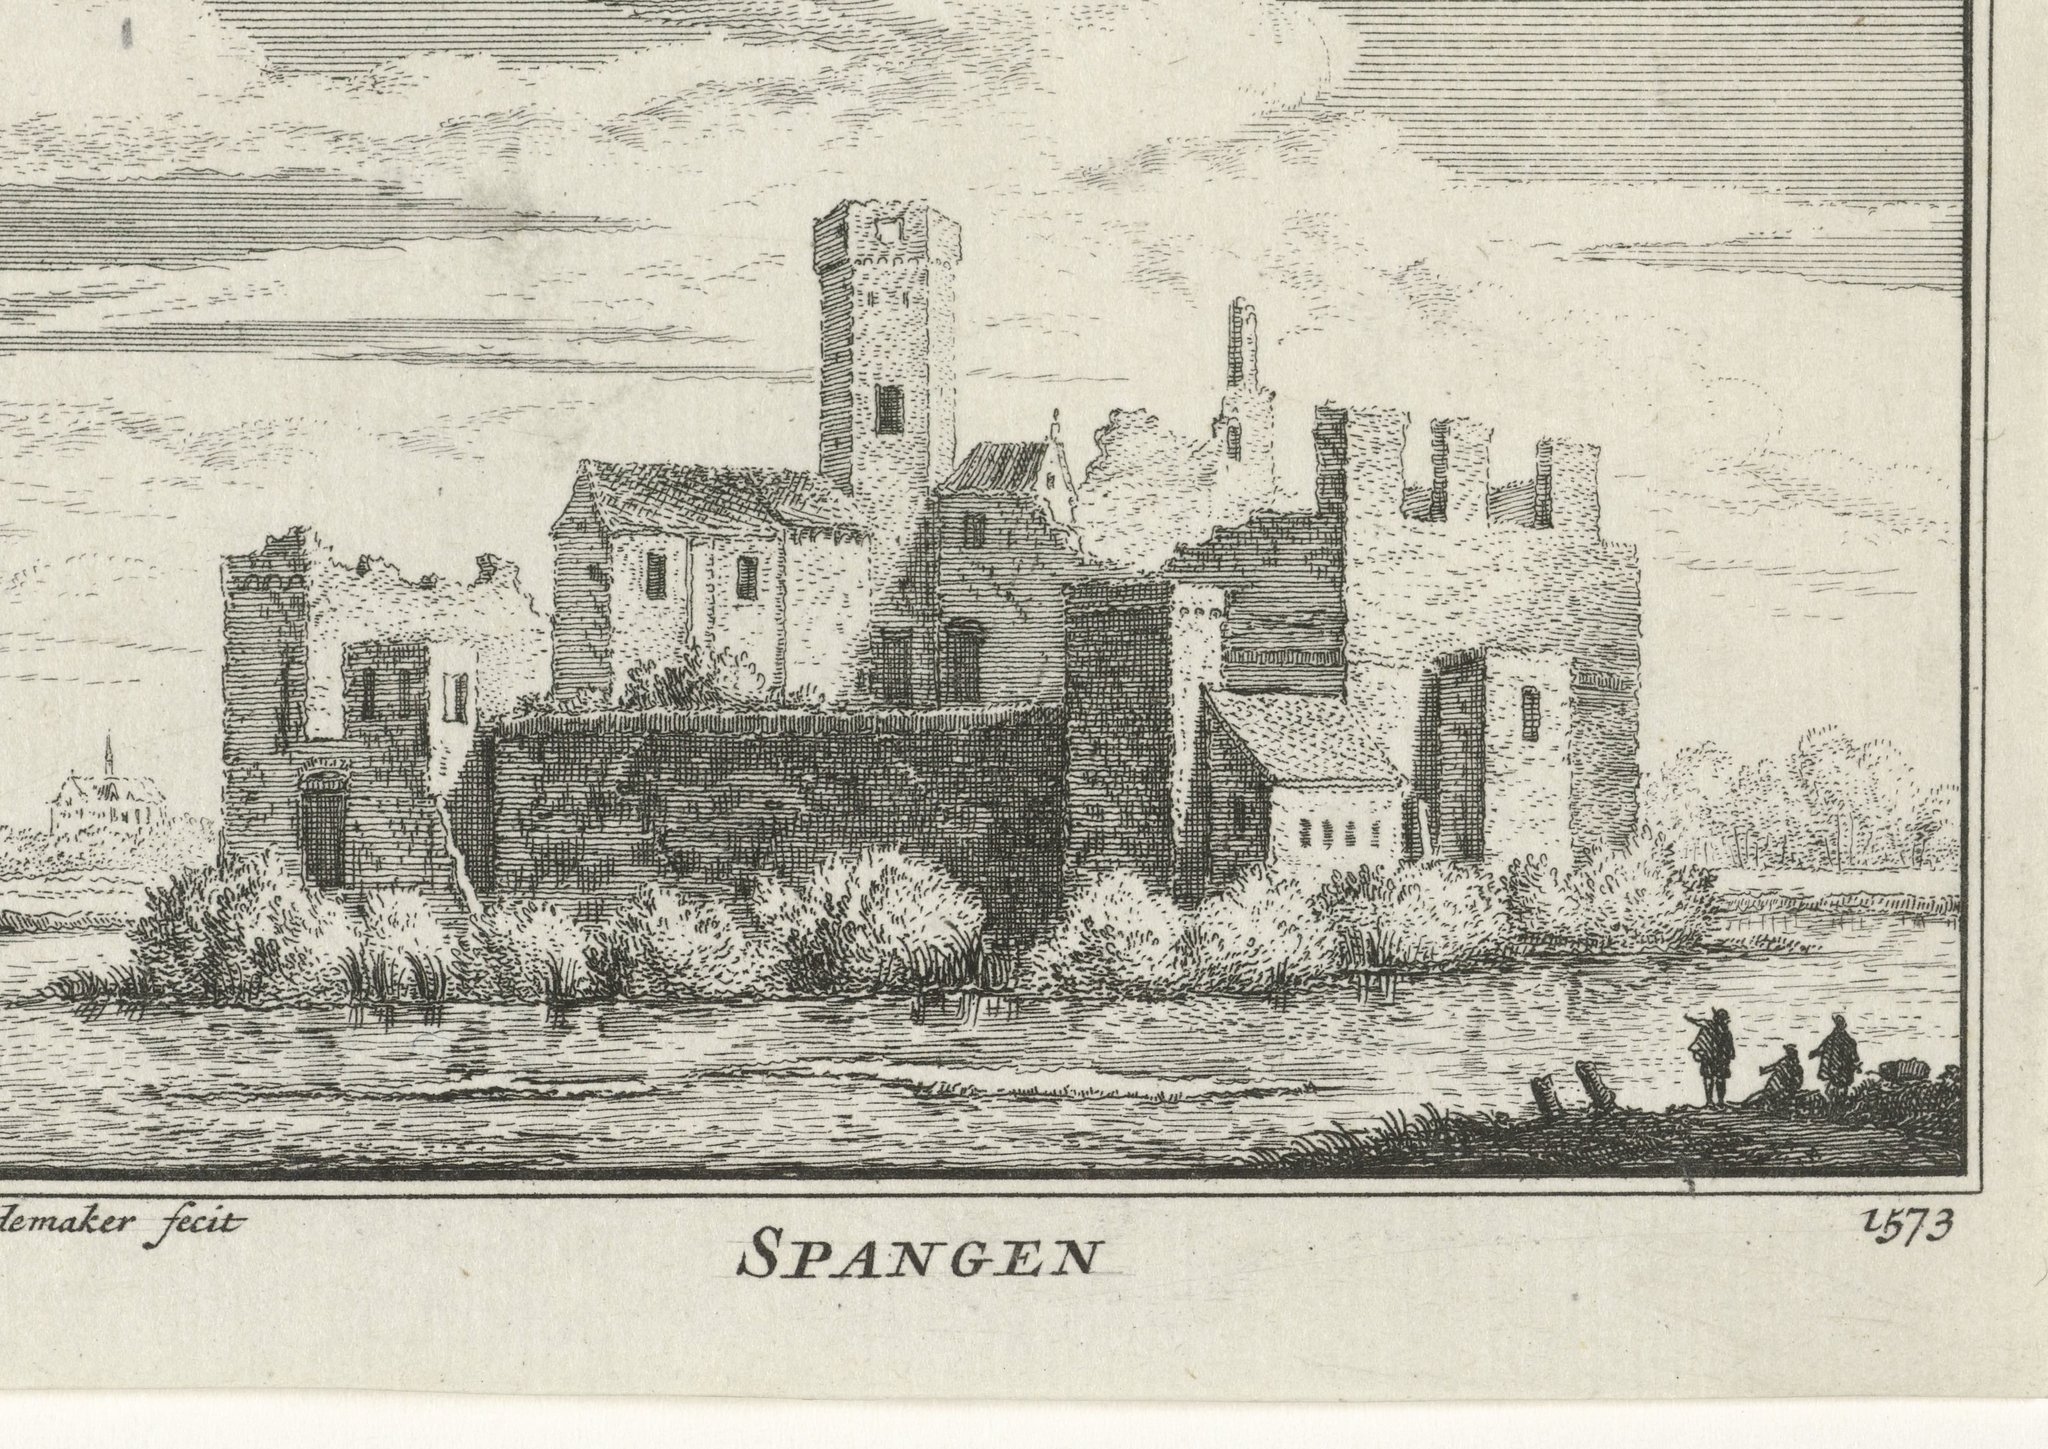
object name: print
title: Spangen 1573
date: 1727-1733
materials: paper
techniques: etching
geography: amsterdam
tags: ruin of a dwelling, house, castle, etc.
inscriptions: collector's mark: Lugt 2228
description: Illustratie uit: Abraham Rademaker, Matthaeus Brouërius van Niedek, Isaac Le Long, Kabinet van Nederlandsche en Kleefsche outheden en (...) voorname stads- en landgebouwen, Willem Barents en Antoni Schoonenburg: Amsterdam, 1727-1733, ill. nr. 144.